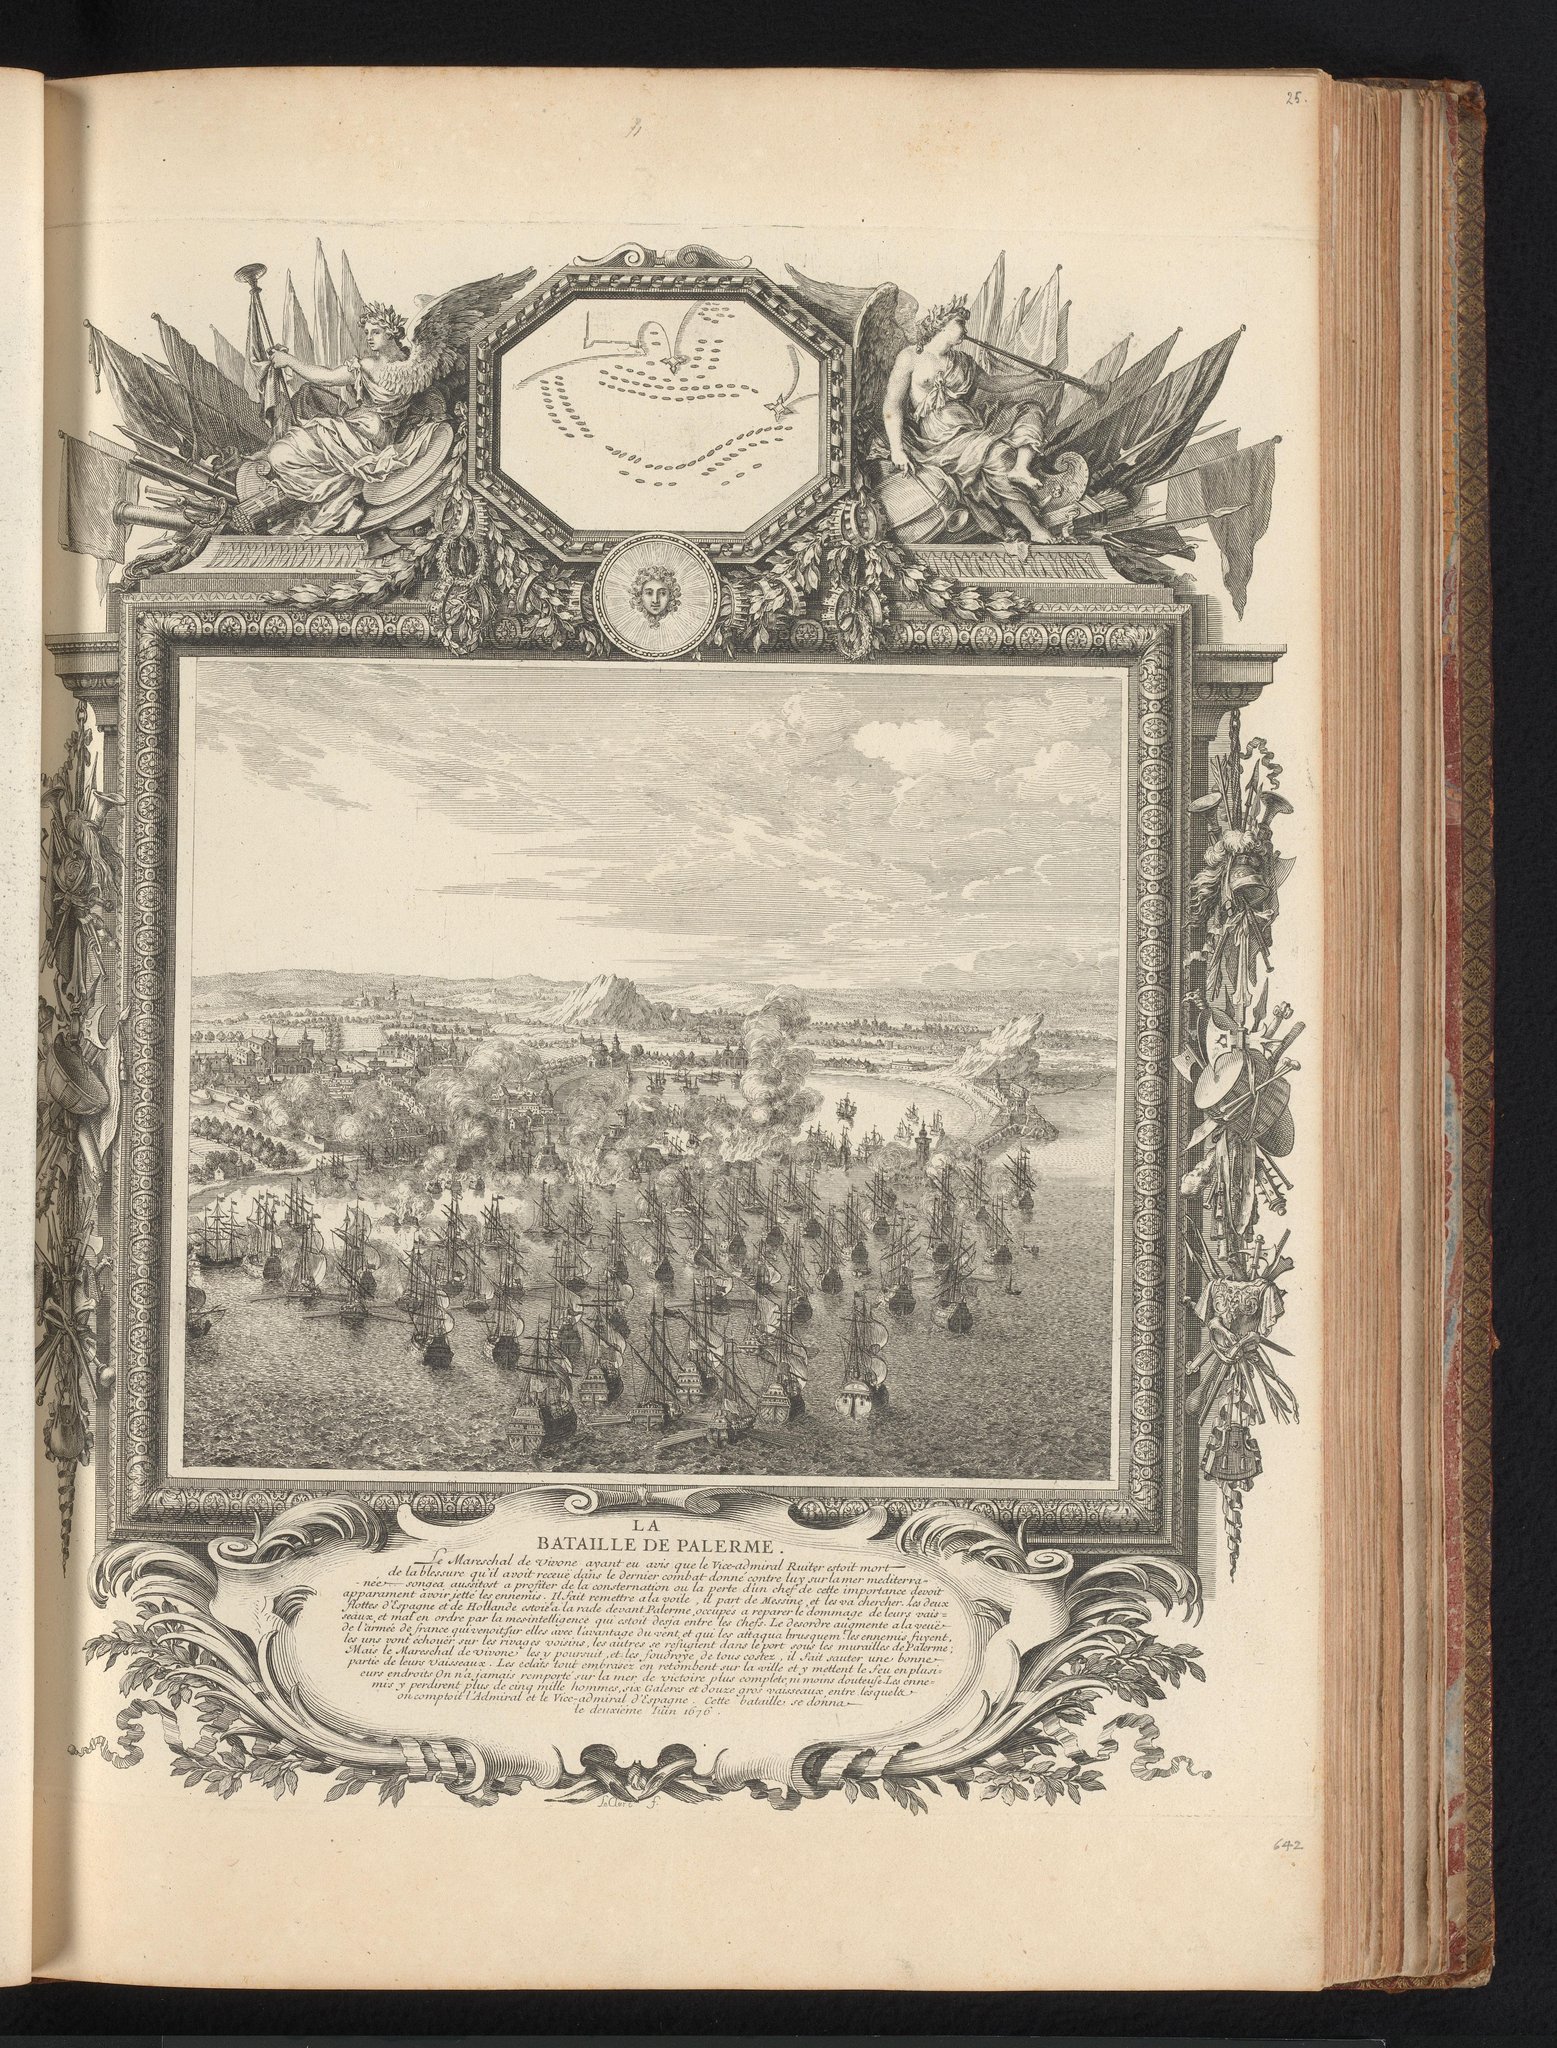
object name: album leaf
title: La Bataille de Palerme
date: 1690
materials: paper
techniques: engraving, etching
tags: paris, louis victor rochechouart de mortemart, historical persons, battle (+ sailing-ships)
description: Maakt deel uit van een serie bestaande uit 28 prenten met oorlogstaferelen in ornamentele cartouches. De prenten zijn gedrukt van twee afzonderlijke platen bestaande uit de voorstelling en de cartouche.